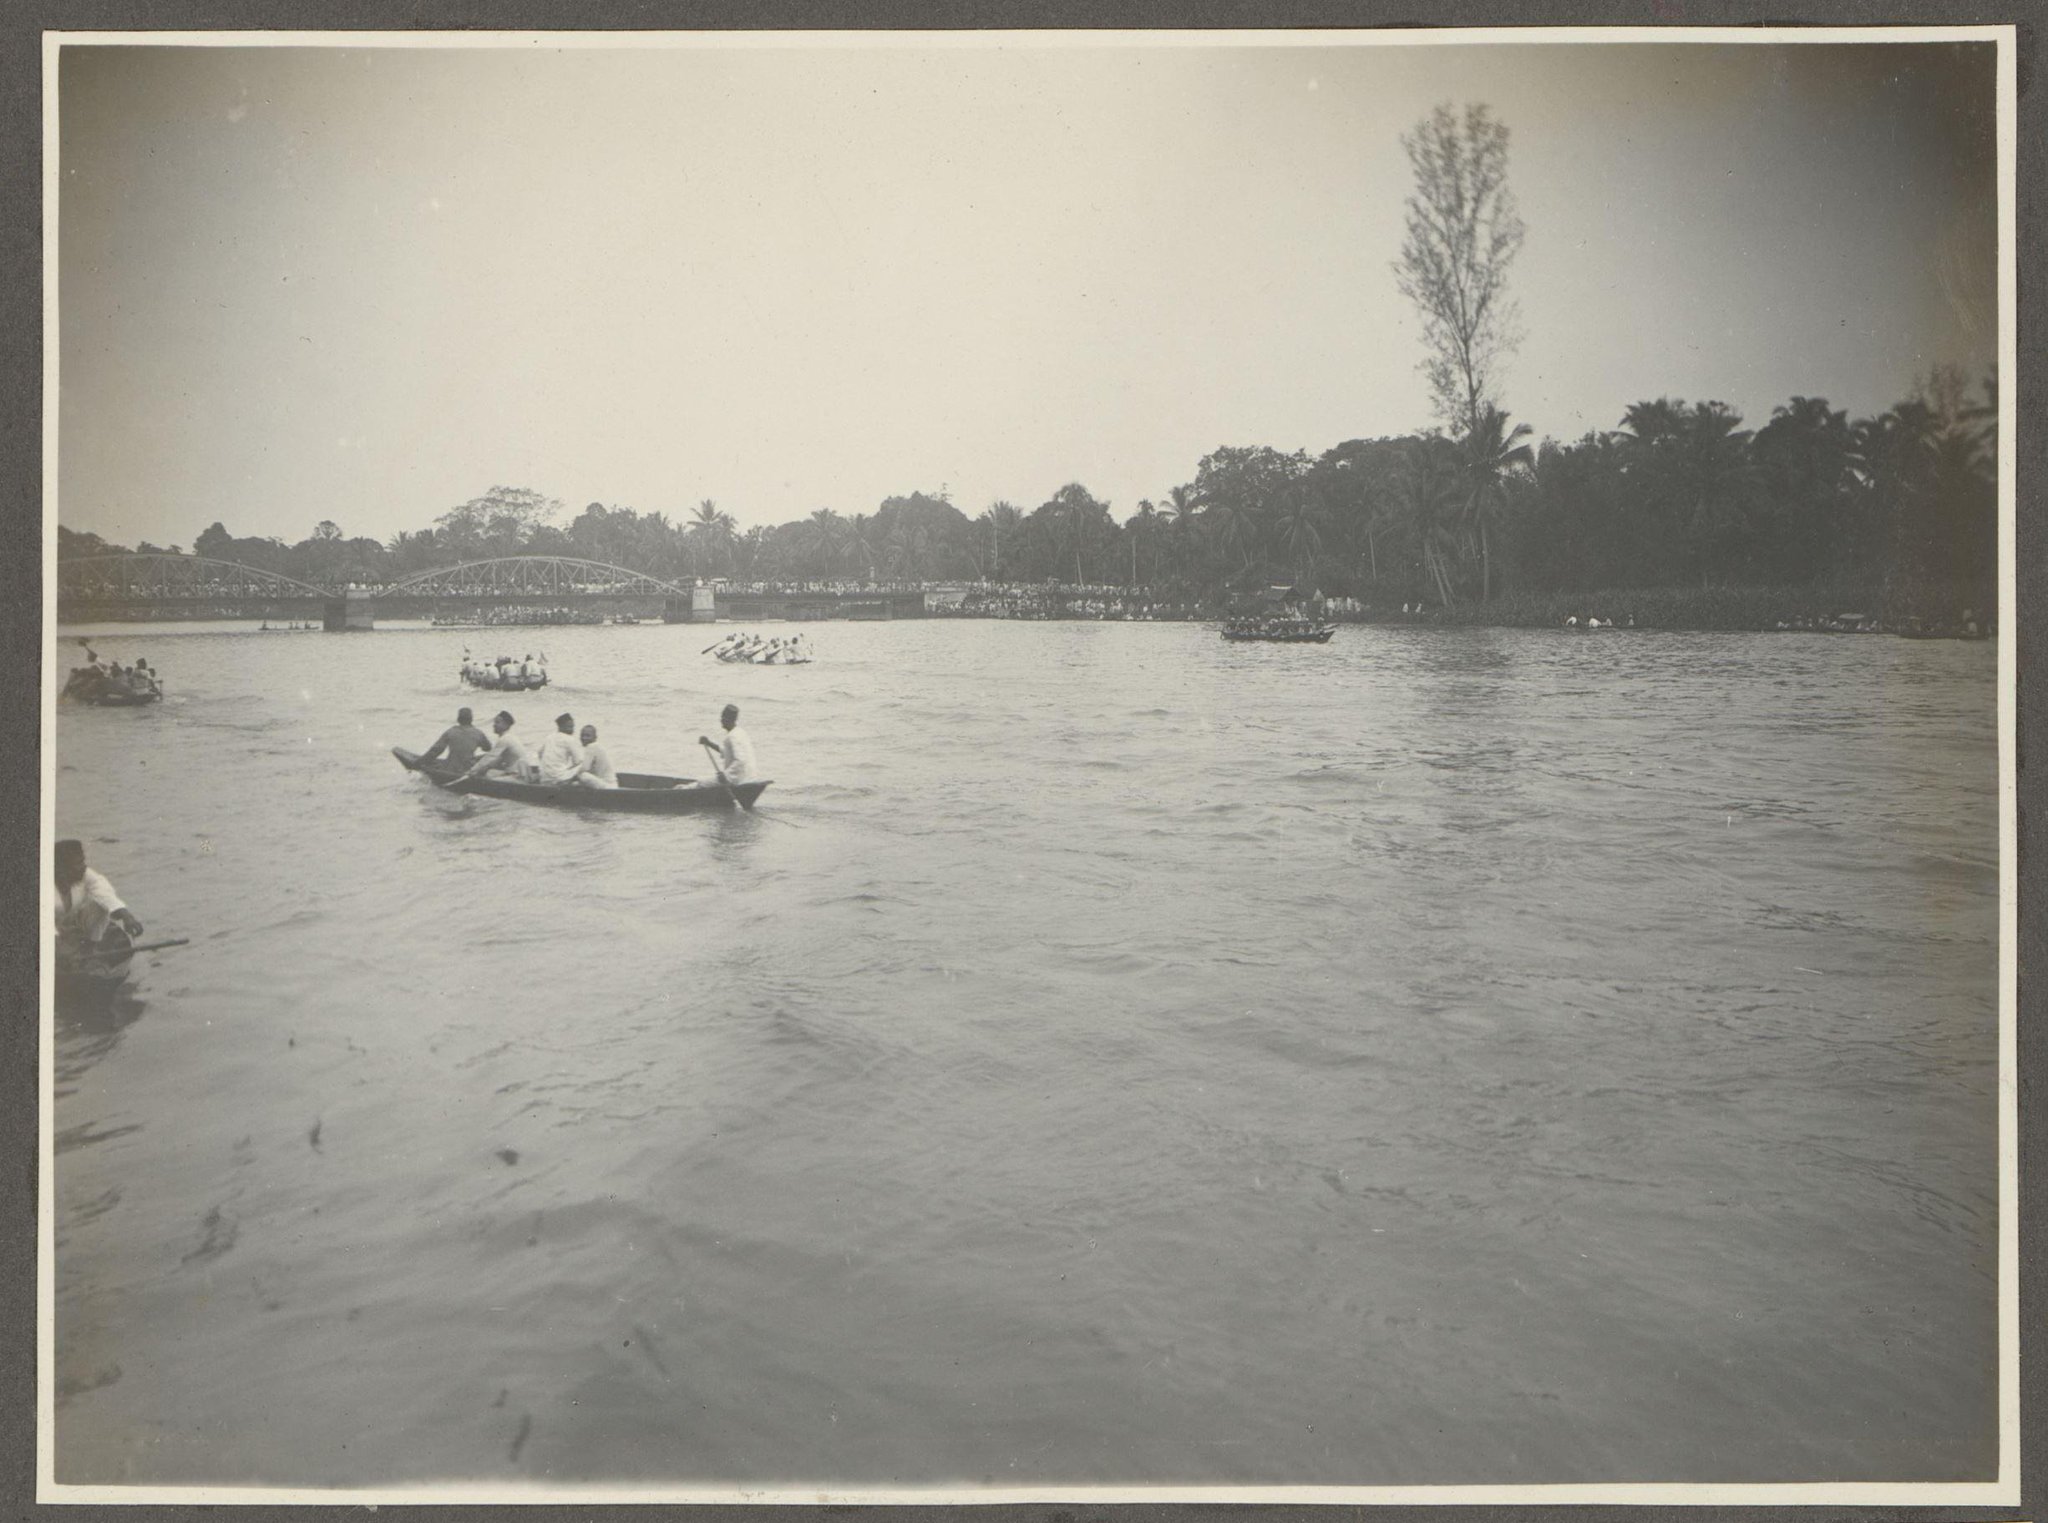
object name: album leaf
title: Roeiwedstrijden bij het jubileum van de Sultan op de Wampoerivier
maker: Anonymous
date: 1919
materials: photographic support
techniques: gelatin silver print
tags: river, historical persons, rowing, canoeing, etc. (sport)